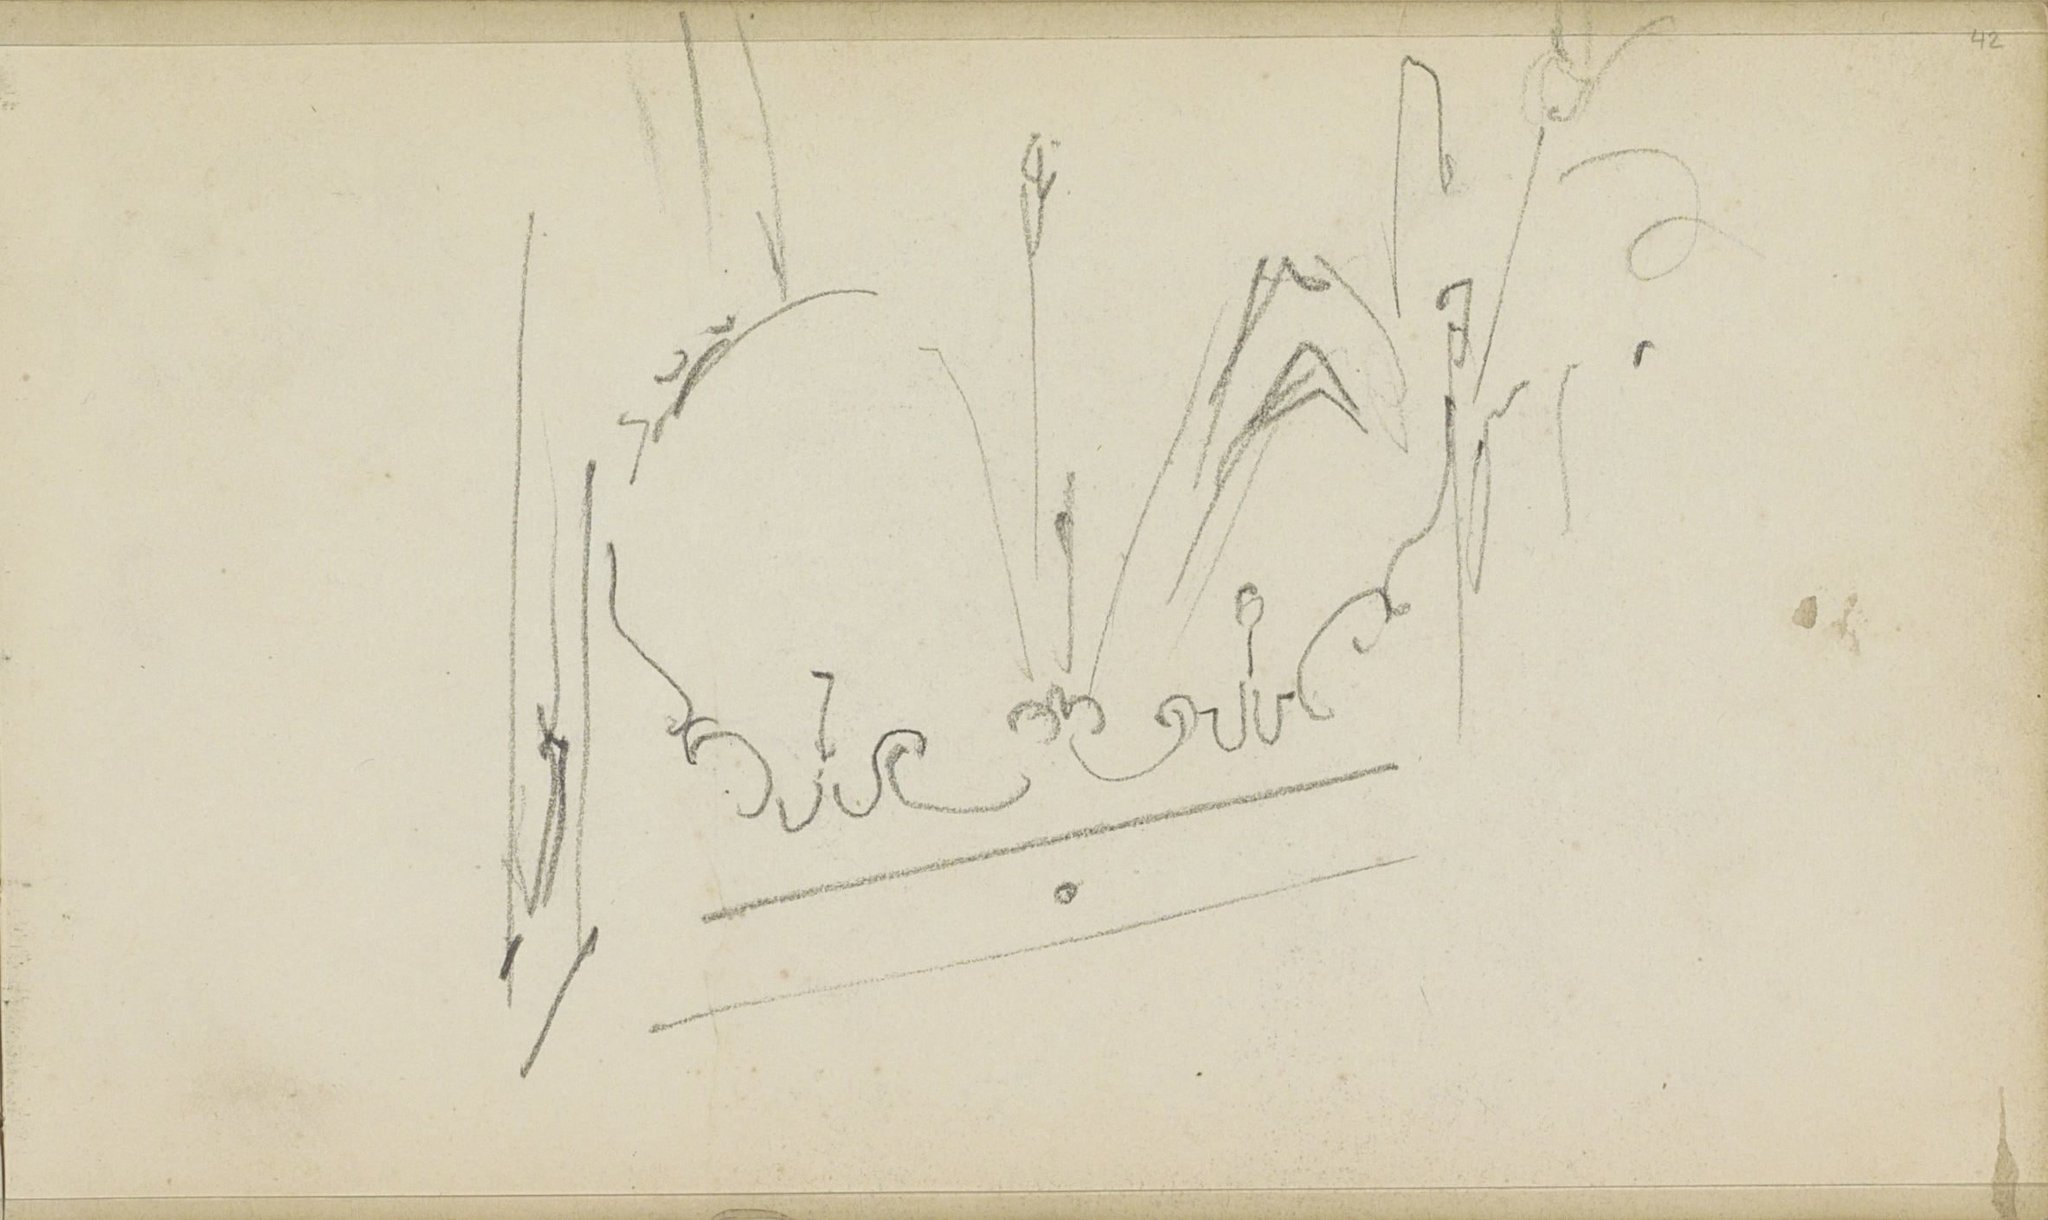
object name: sketchbook leaf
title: Draperie, mogelijk van een baldakijn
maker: johannes bosboom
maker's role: draughtsman, painter, print maker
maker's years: 1817-1891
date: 1845-1891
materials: chalk, paper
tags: canopy, baldachin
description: Blad 42 recto uit een schetsboek met 46 bladen.